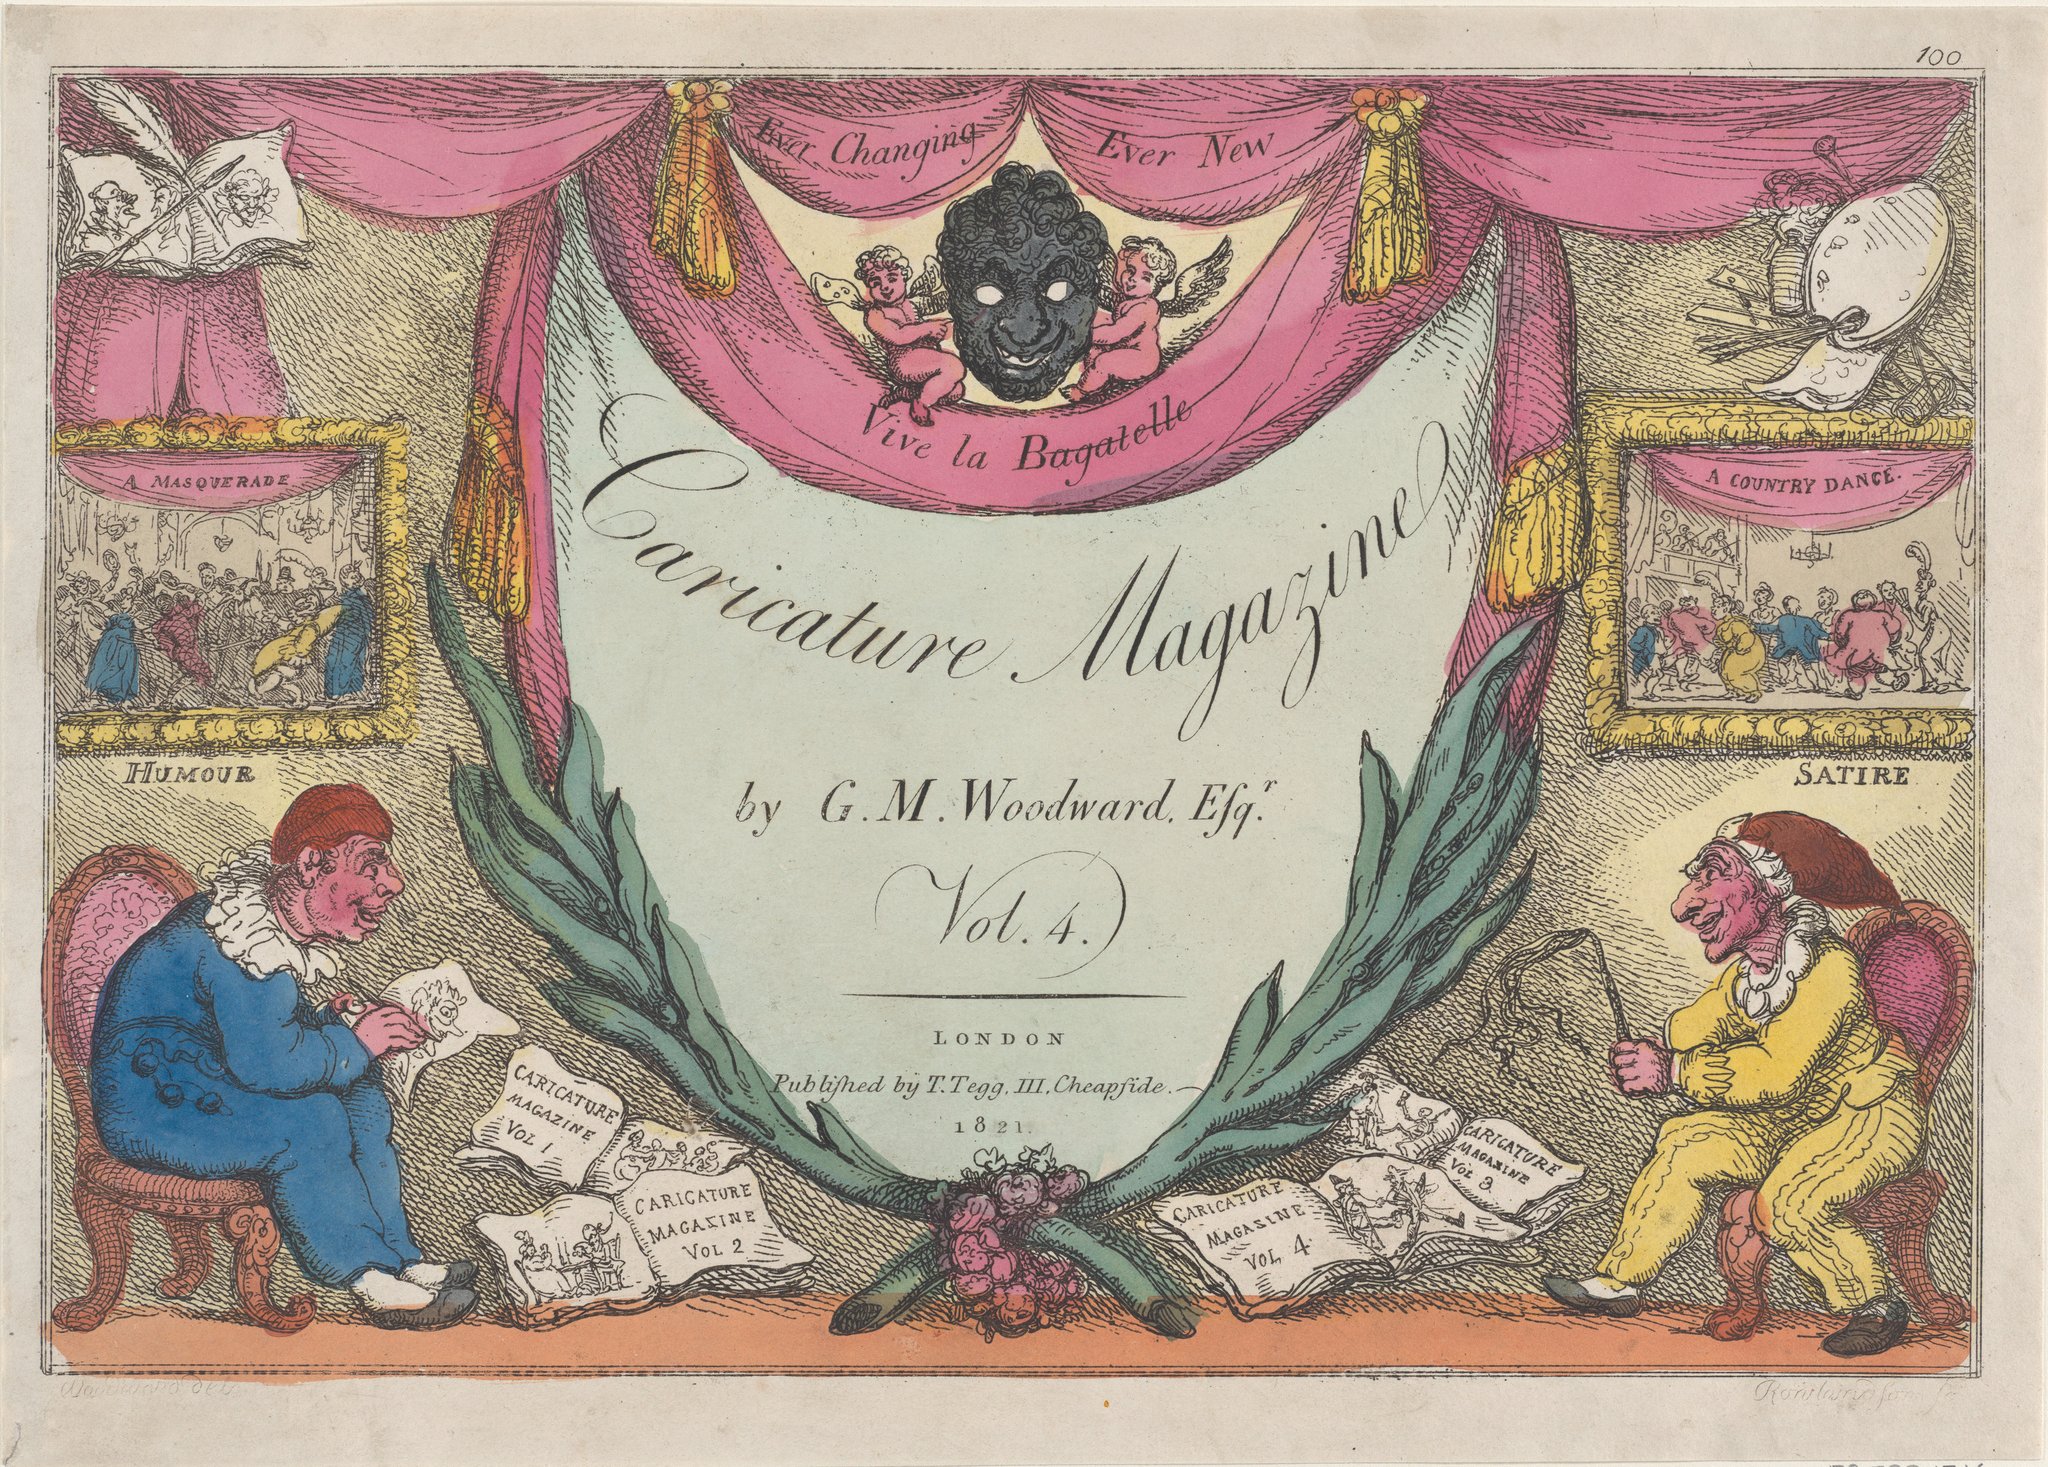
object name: print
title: Title Page, The Caricature Magazine by G. M. Woodward, vol. 4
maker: thomas rowlandson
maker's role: artist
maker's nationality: british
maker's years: 1757-1827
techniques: etching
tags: satire,caricature